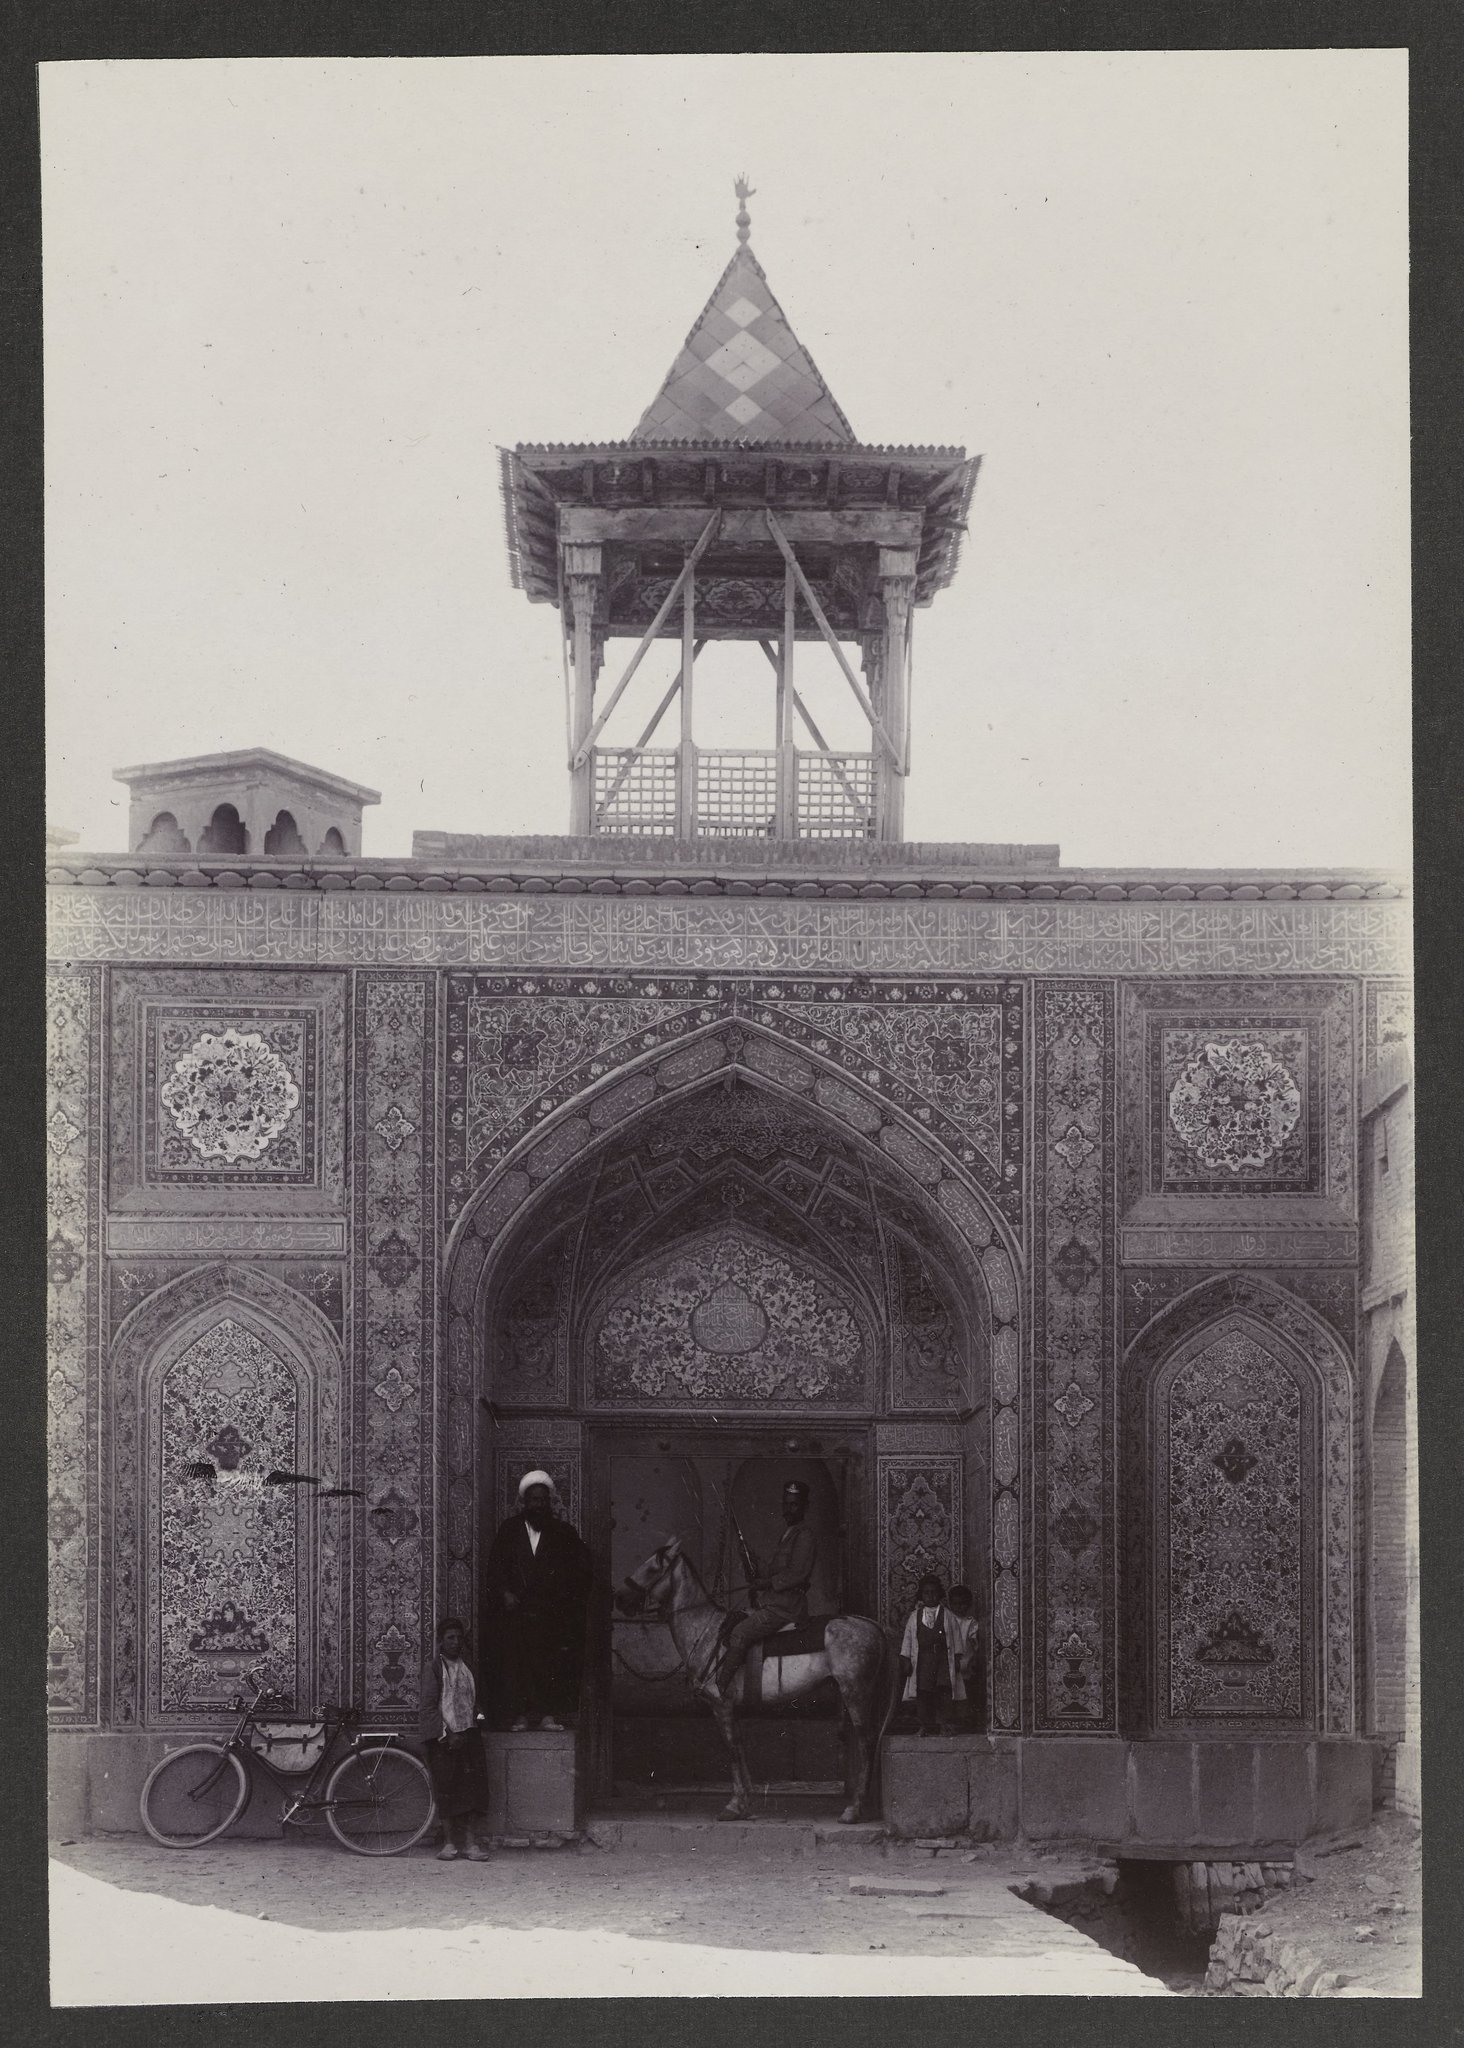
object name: photograph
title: Moskee van de Sjah (Masjed-e Shah) in Isfahan, Perzië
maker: a.g.a. van eelde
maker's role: engineer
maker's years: 1862-1950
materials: cardboard, paper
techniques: gelatin silver print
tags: isfahan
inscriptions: number: ‘45.’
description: Onder de boog in het midden zit een man op een paard.